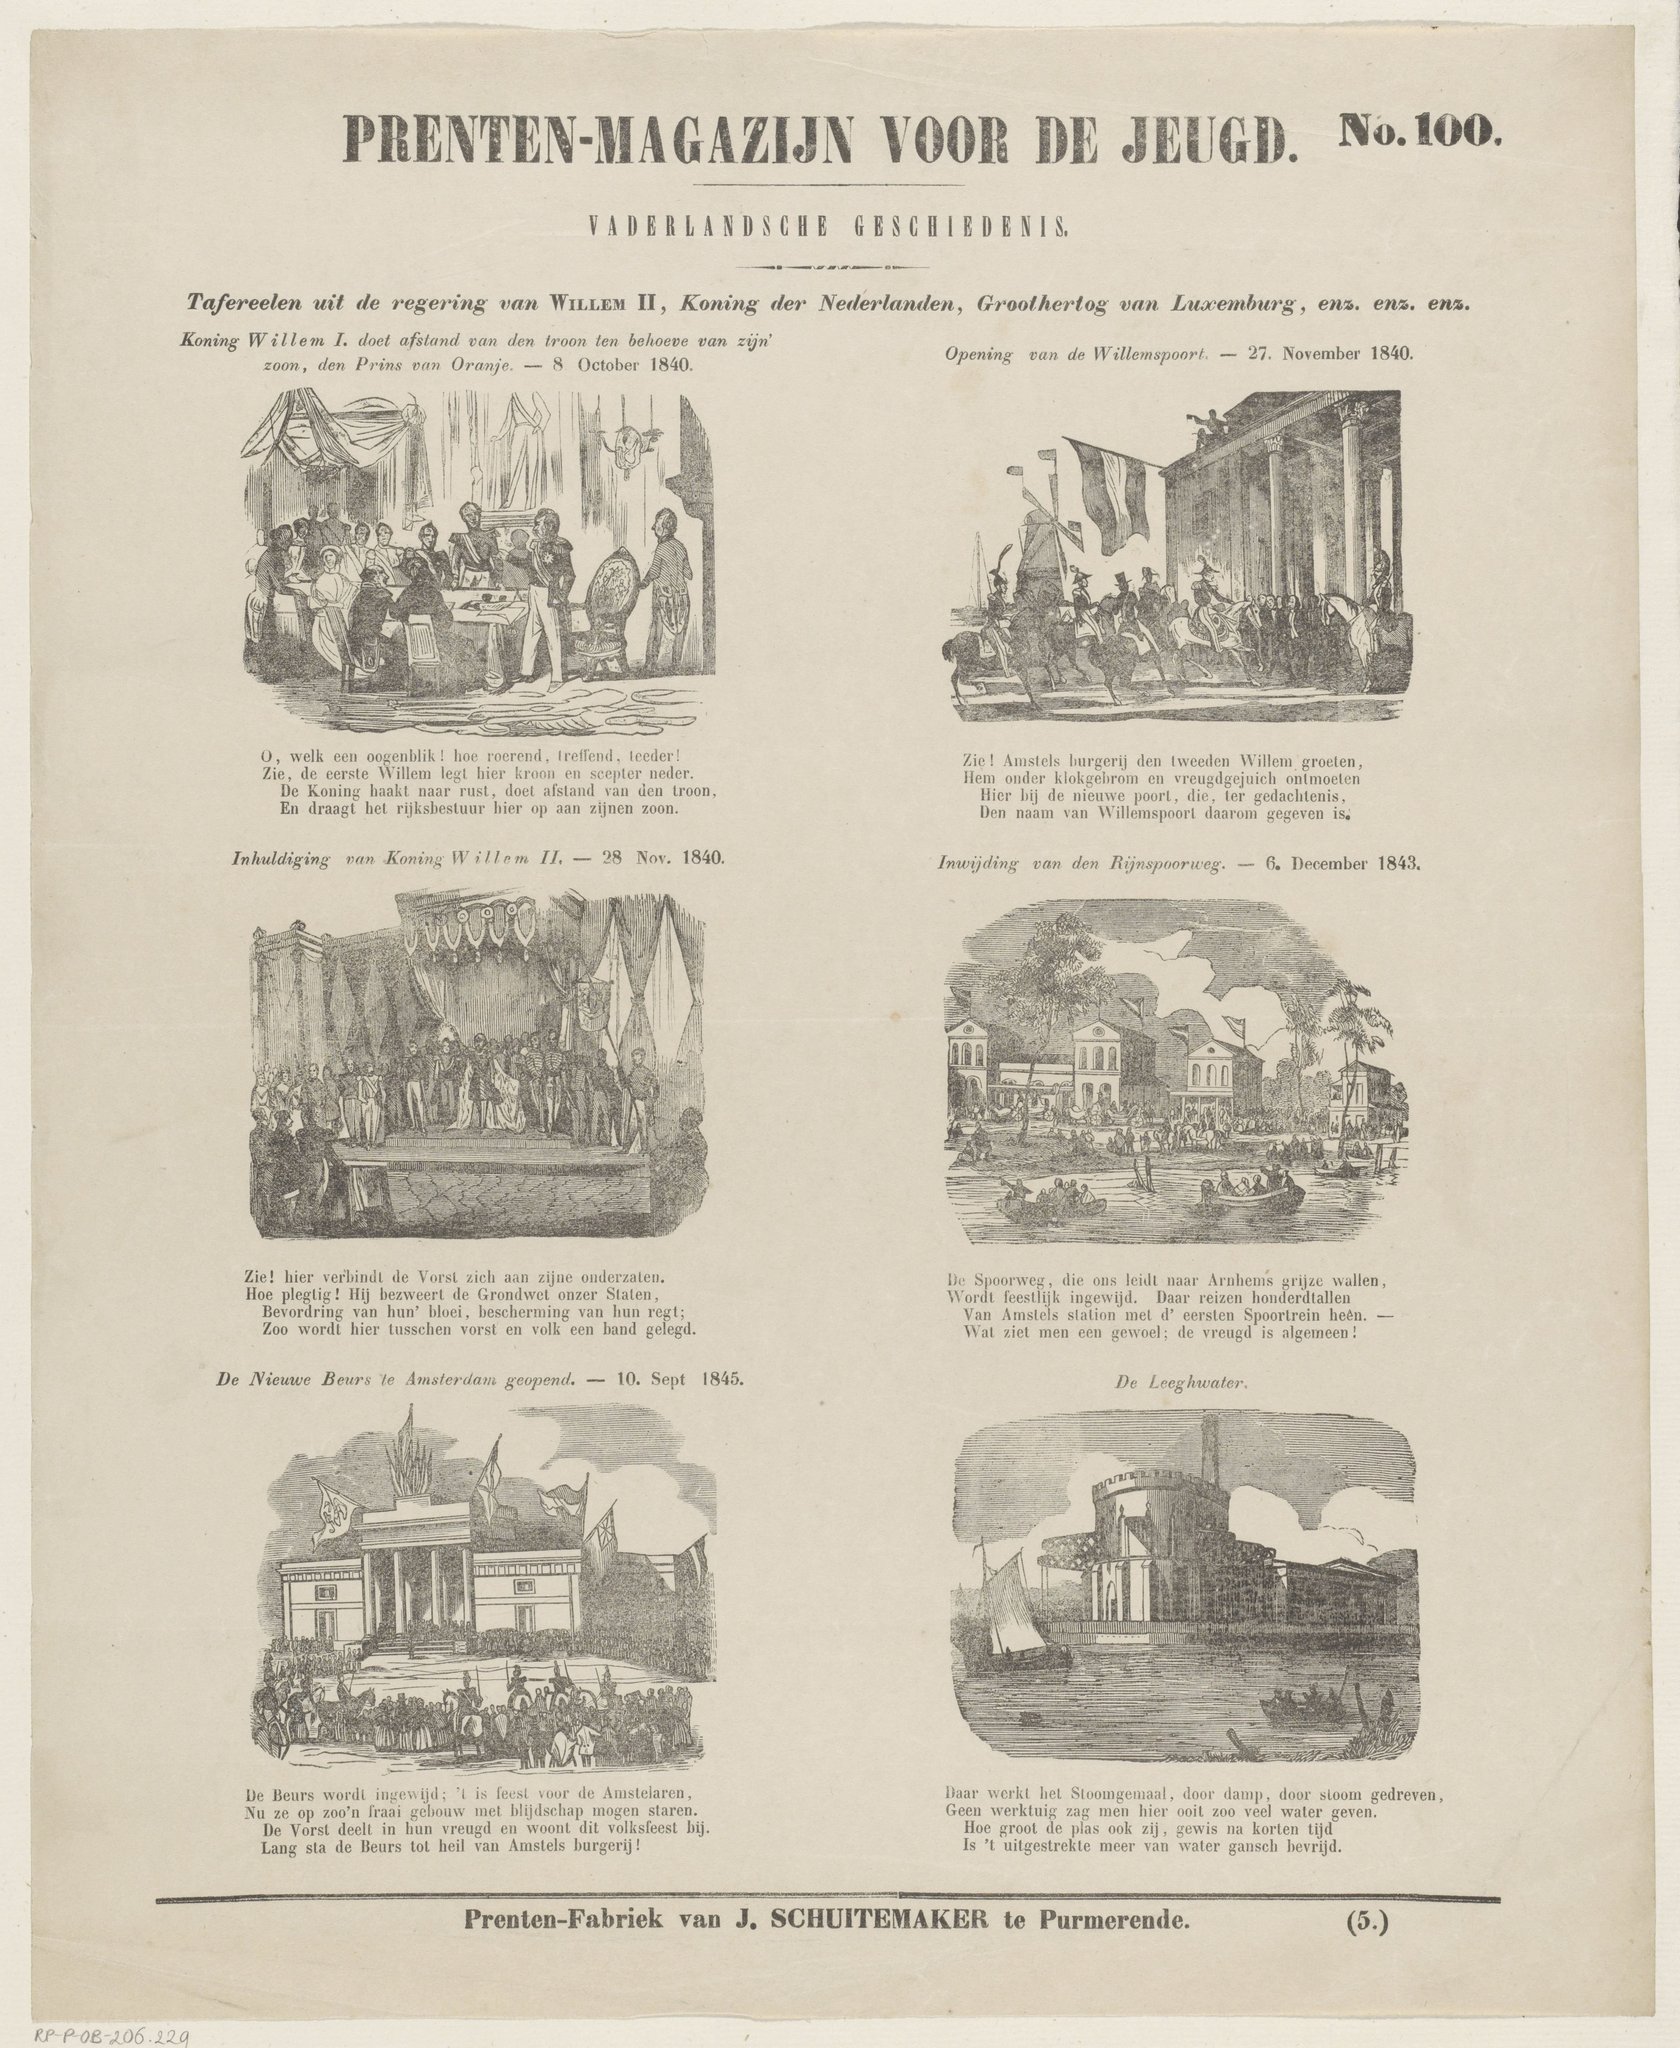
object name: popular print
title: Vaderlandsche geschiedenis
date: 1850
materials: paper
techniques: letterpress printing, engraving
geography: netherlands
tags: the hague, berlin, william i of the netherlands, william ii of the netherlands, history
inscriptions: collector's mark: Lugt 2760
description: Na voltooiing van de acht jaargangen van de reeks 'Prenten-magazijn voor de jeugd' in 1850 heeft Jan Schuitemaker al deze prenten heruitgegeven en omgenummerd als nr. 1 t/m 192. De oorspronkelijke jaargang wordt telkens nog vermeld rechtsonder op de prent. Binnen de jaargangen zijn prenten van hetzelfde thema in clusters van vier achter elkaar gezet.